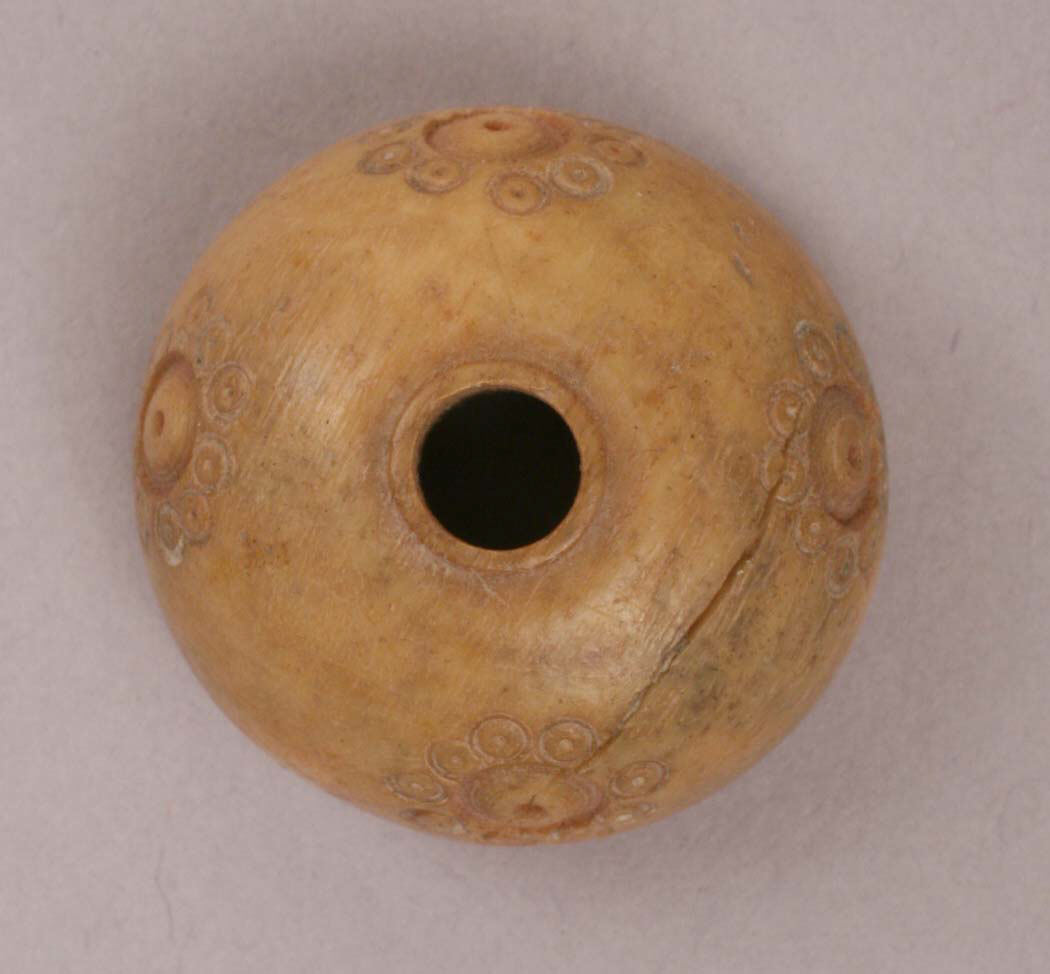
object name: button or spindle whorl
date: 801-1000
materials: bone, paint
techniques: incising, inlay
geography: iran